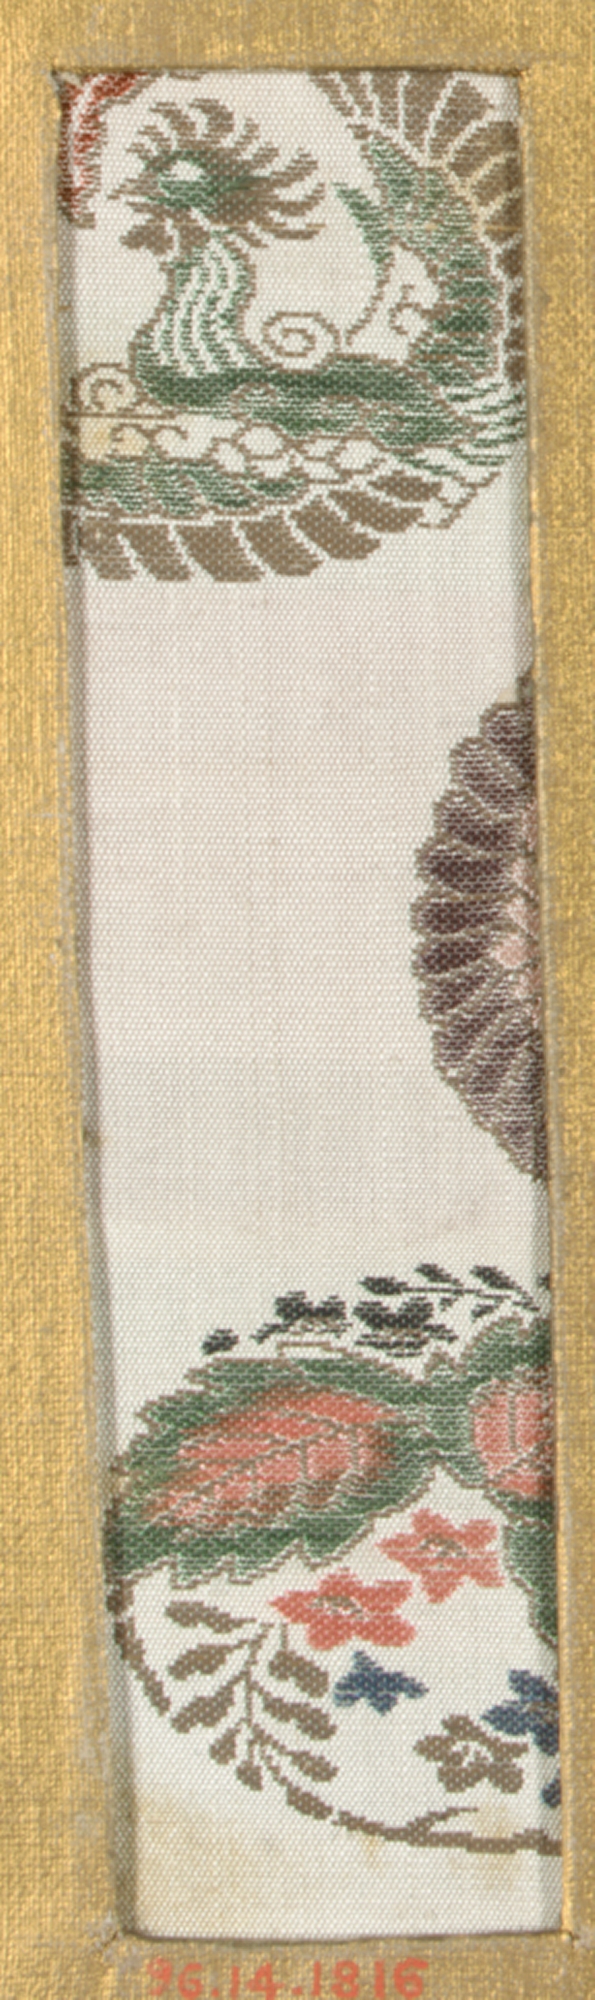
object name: piece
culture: japanese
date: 1701-1900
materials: silk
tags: birds